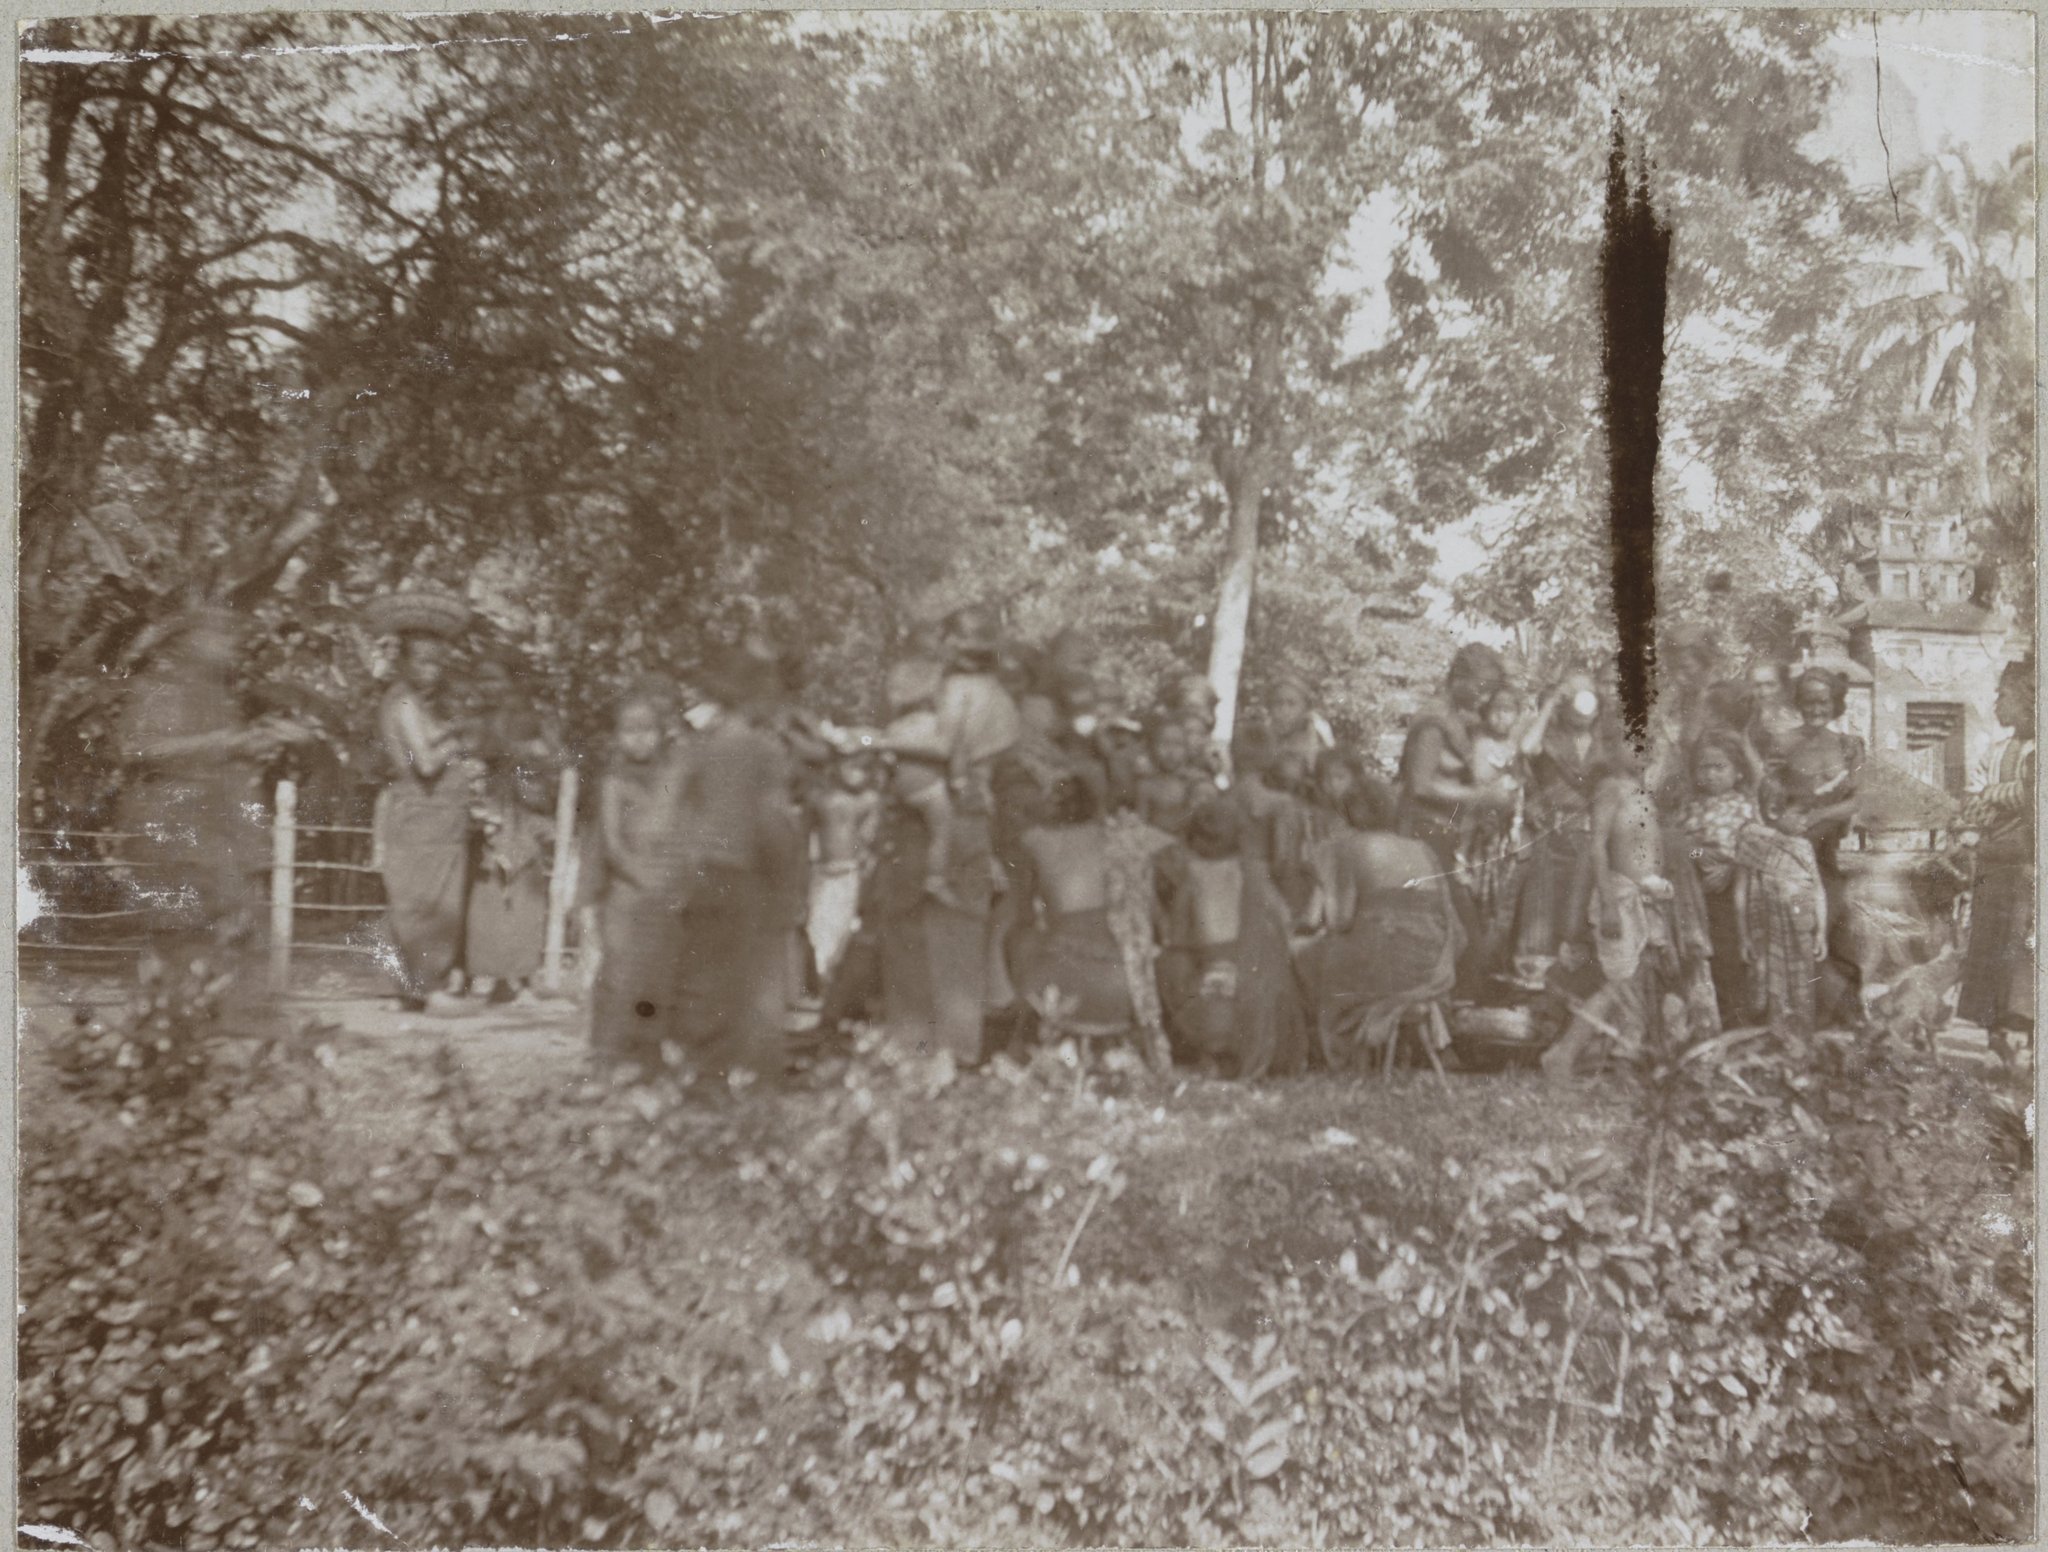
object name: photograph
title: Groep mensen bij lijkverbrandingsfeest , Bali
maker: Anonymous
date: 1910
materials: cardboard, paper, photographic support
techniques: collodion silver print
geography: bali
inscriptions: annotation: ‘Lijkverbrandingsfeesten te Bali 1910.’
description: Foto genomen tijdens lijkverbrandingsfeesten op Bali in 1910.